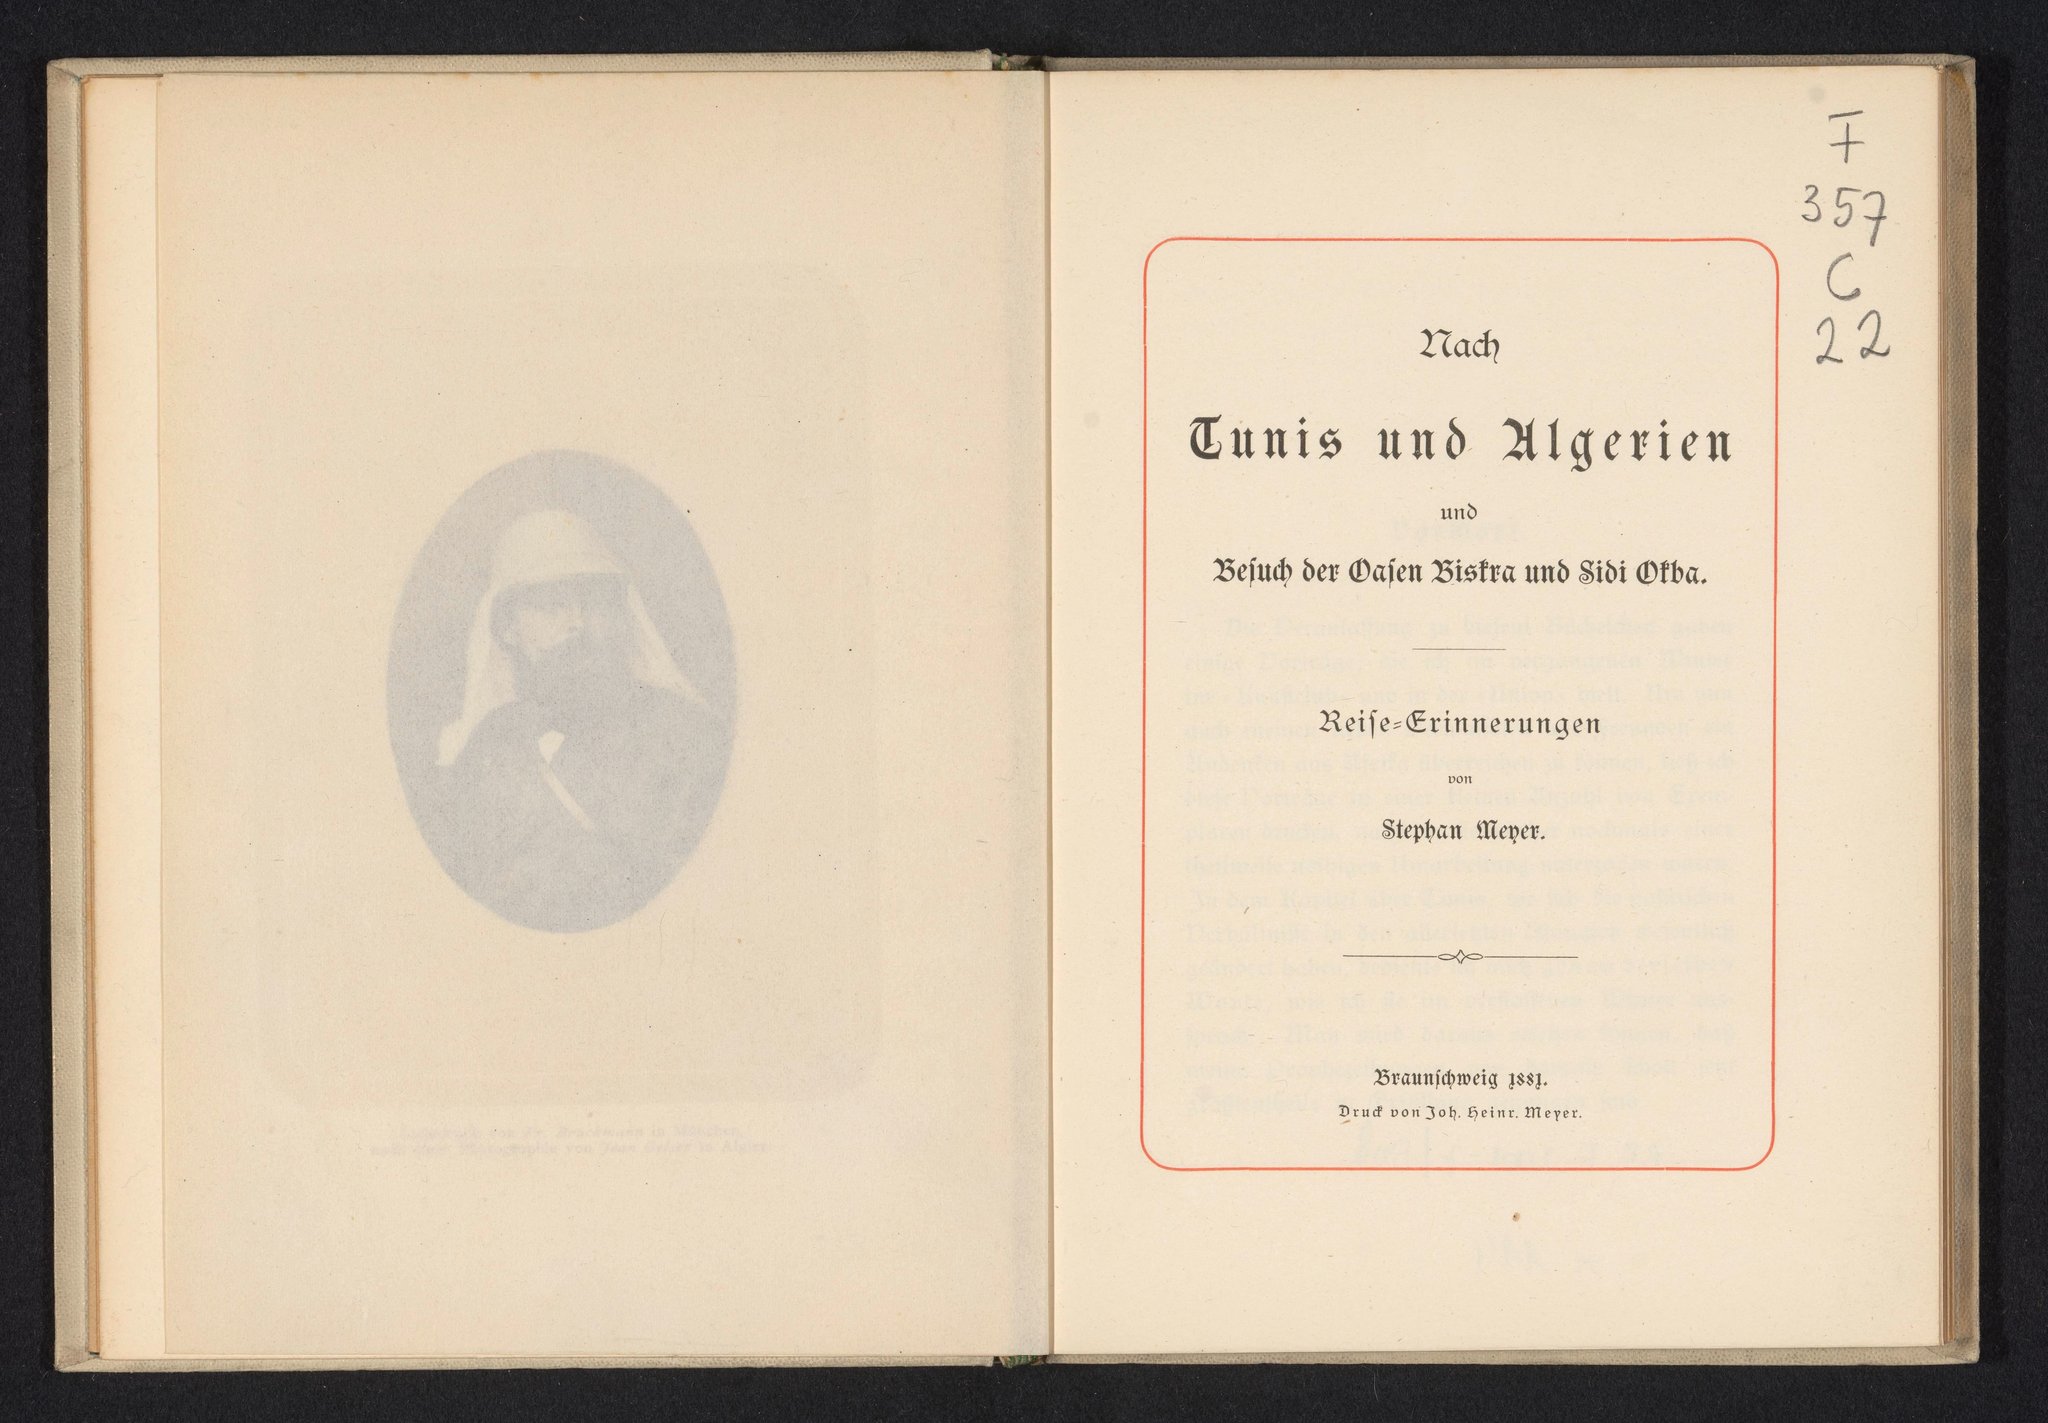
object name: book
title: Nach Tunis und Algerien und Besuch der Oasen Biskra und Sidi Okba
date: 1881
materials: cardboard, linen, paper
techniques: photograph, printing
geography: braunschweig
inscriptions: inscription: ‘[...] lieben [...] Louise Bahr [...]’